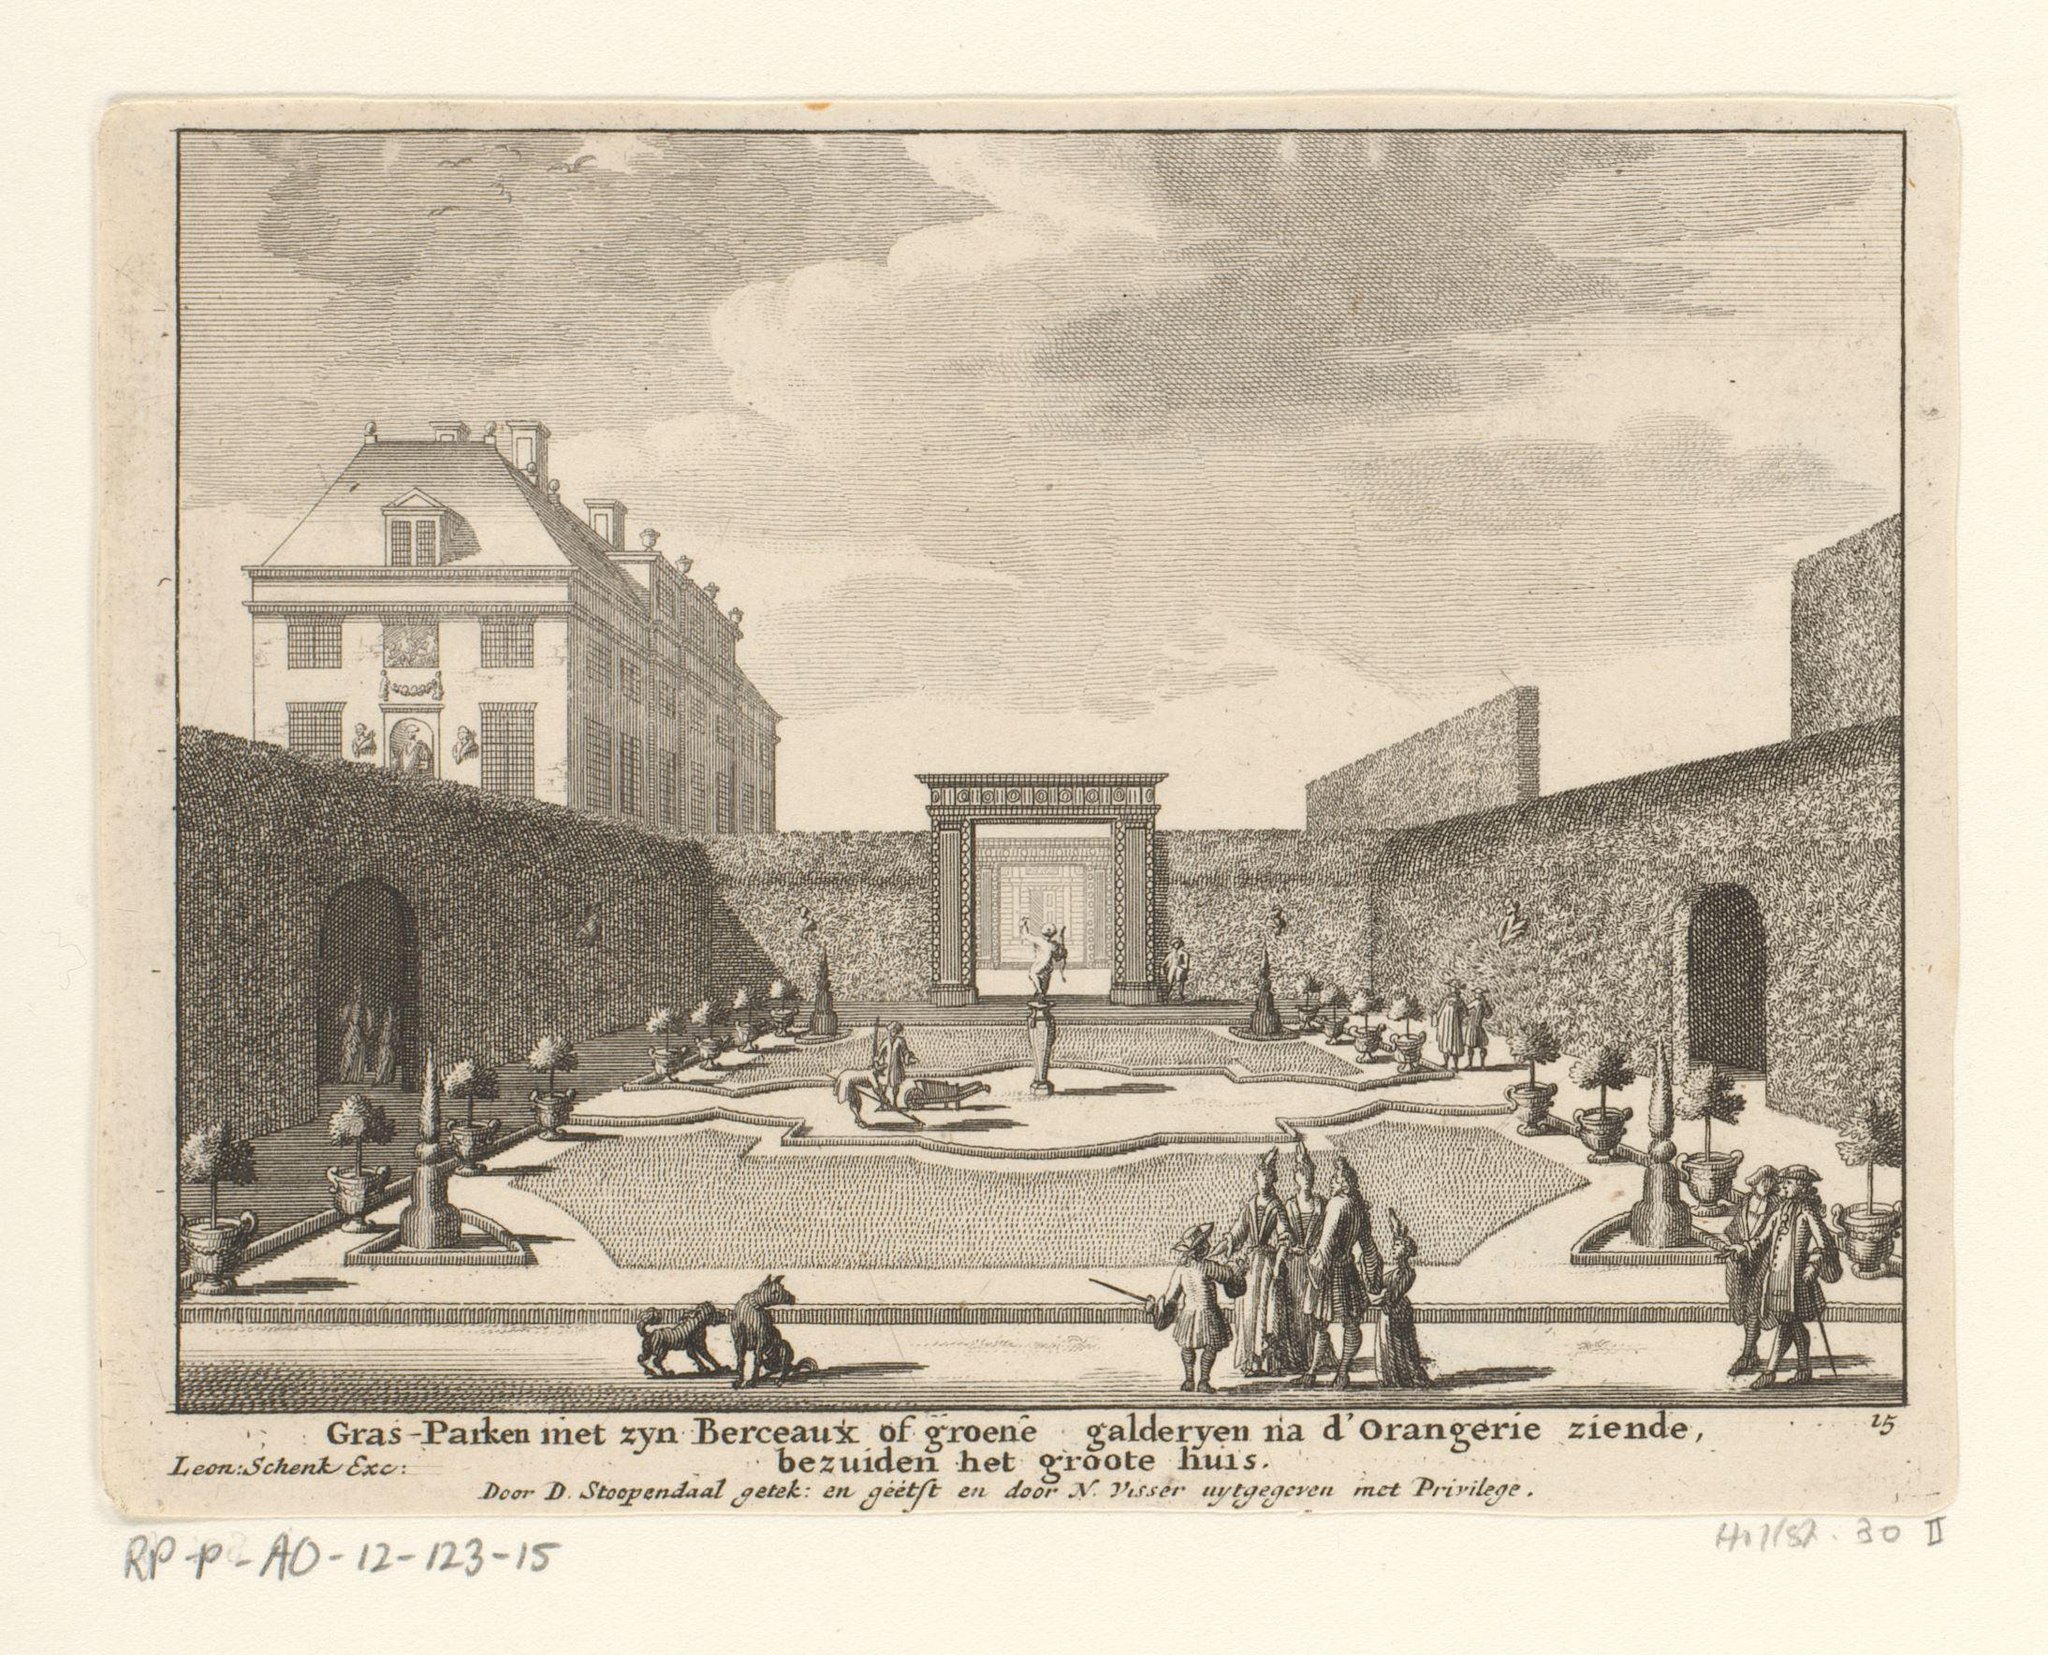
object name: print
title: Verscheyde schoone en vermaakelyke gezigten in de Hofstede van Clingendaal gelegen by 's Gravenhage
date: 1682-1726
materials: paper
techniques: etching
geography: amsterdam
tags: french or architectonic garden; formal garden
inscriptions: collector's mark: Lugt 2228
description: Gezicht op de grasperken tussen de metershoge groene galerijen of berceau aan de zuidkant van Huis Clingendael te Den Haag. In het midden een standbeeld van Amor. In de tuin wandelen elegante figuren.